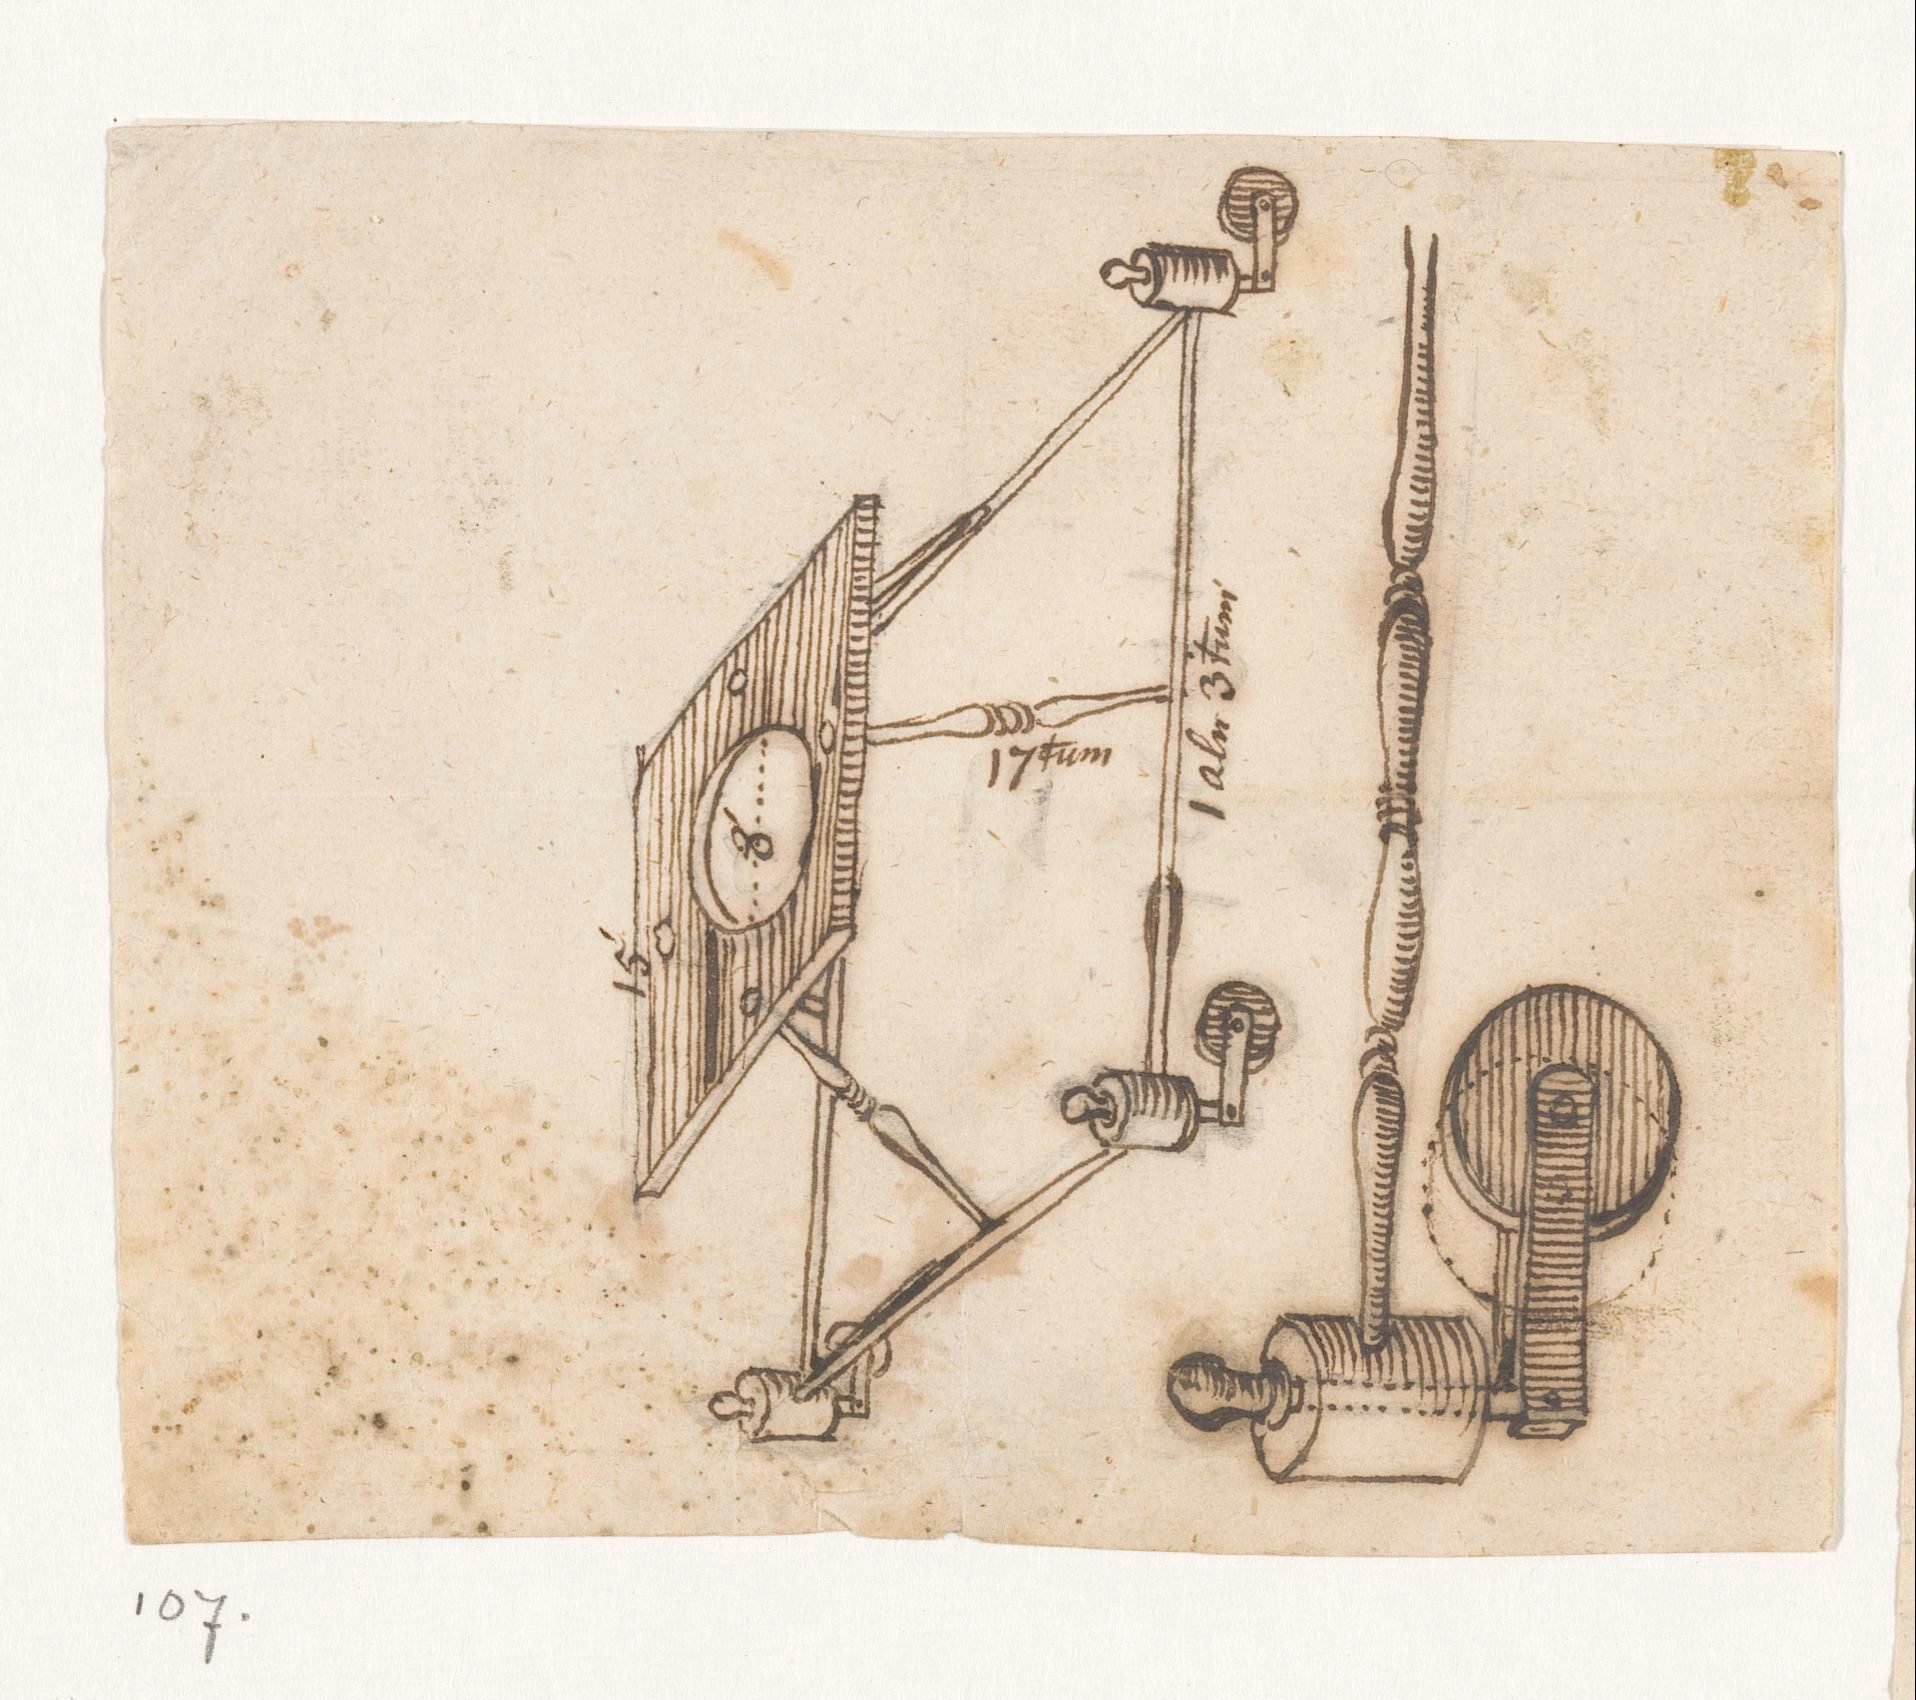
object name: drawing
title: Verrijdbare lens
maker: jan brandes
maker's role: draughtsman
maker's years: 1743-1808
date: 1787-1808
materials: ink, paper, pencil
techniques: pen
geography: skälsebo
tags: lens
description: Ontwerp voor de constructie van een verrijdbaar optisch instrument met lens.